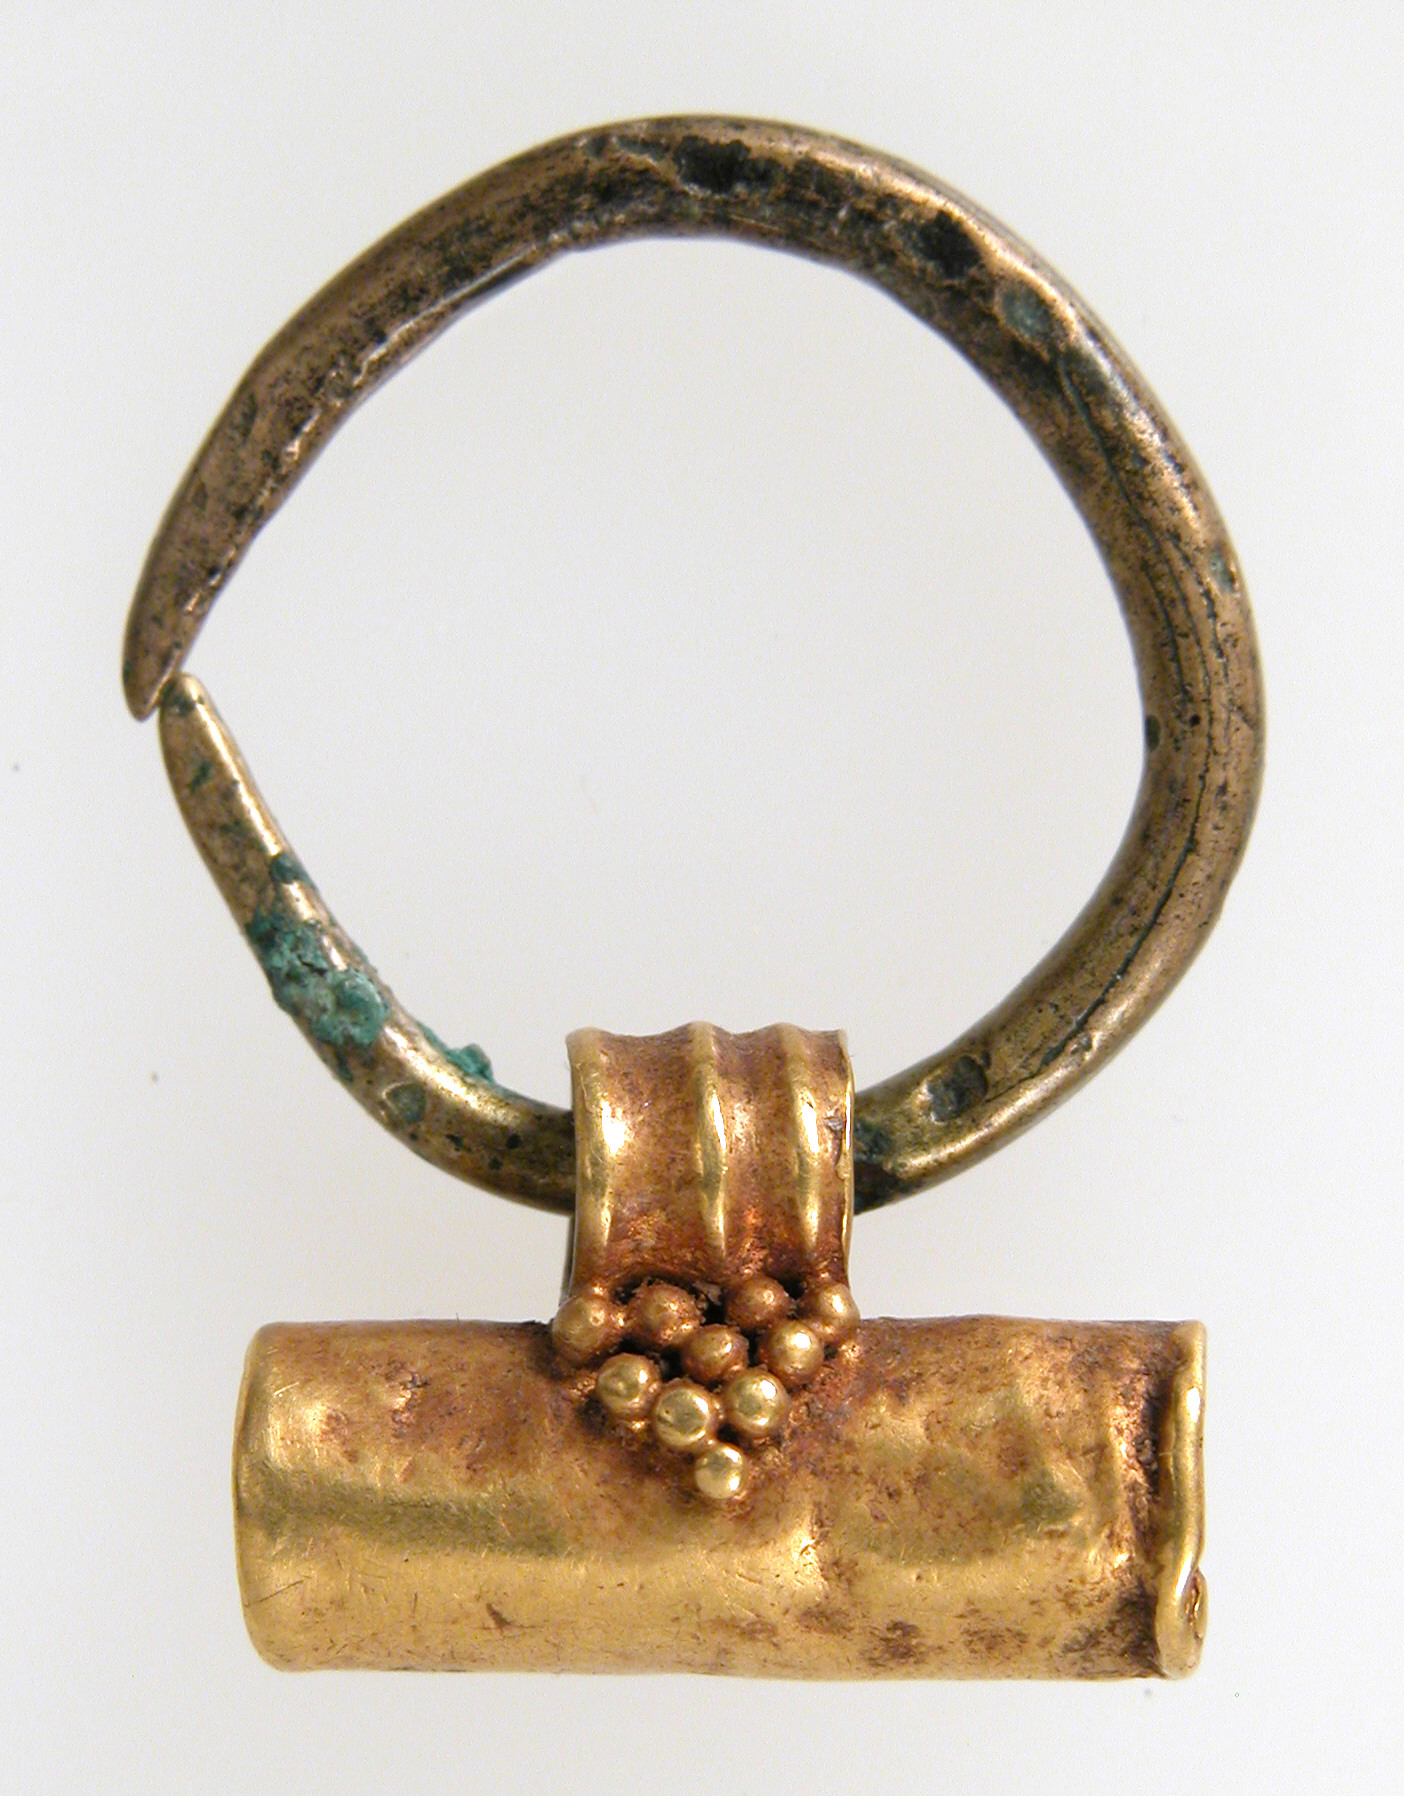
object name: ring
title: Finger Ring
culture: european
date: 500-700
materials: gold